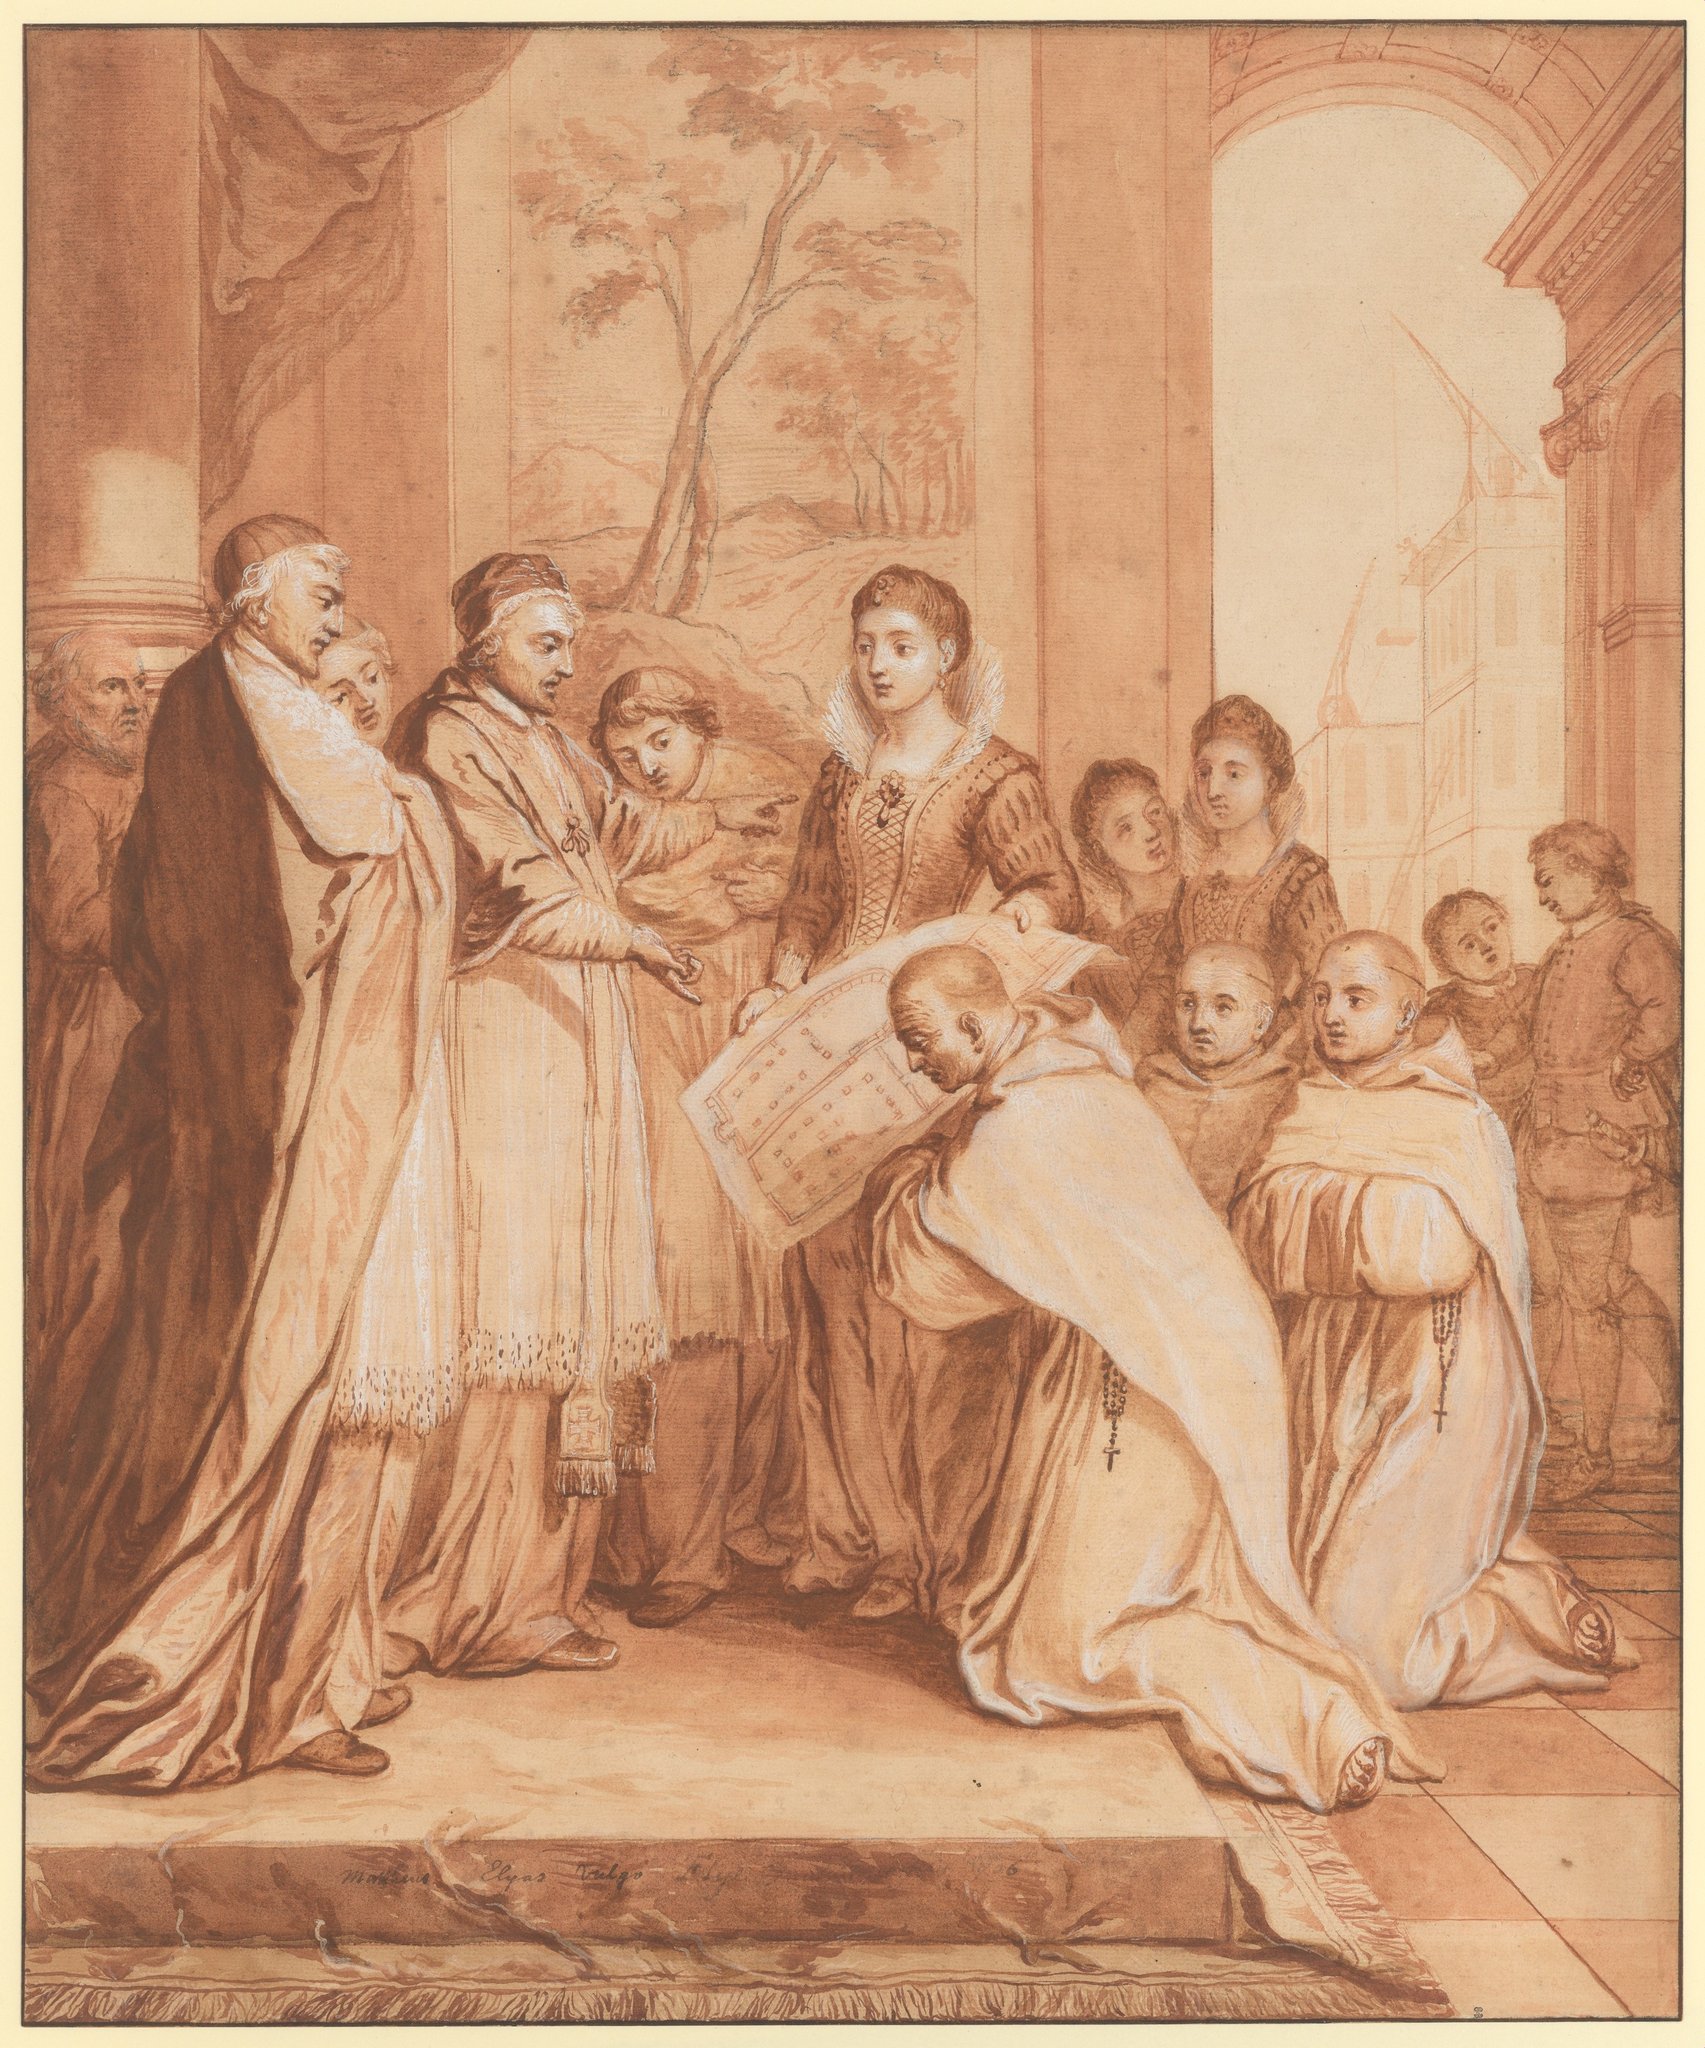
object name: drawing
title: Scene 31: Foundation of a second Feuillant monastery in Rome, dedicated to Saint Bernard, in 1594, thanks to the generosity of Caterina de' Nobili, niece of Pope Julius III and widow of Count Sforza Sforza di Santa Fiora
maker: matthieu elias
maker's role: artist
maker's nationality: french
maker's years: 1658-1741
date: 1706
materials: chalk, graphite, ink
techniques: brush, heightening, pen, wash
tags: men,women,monks